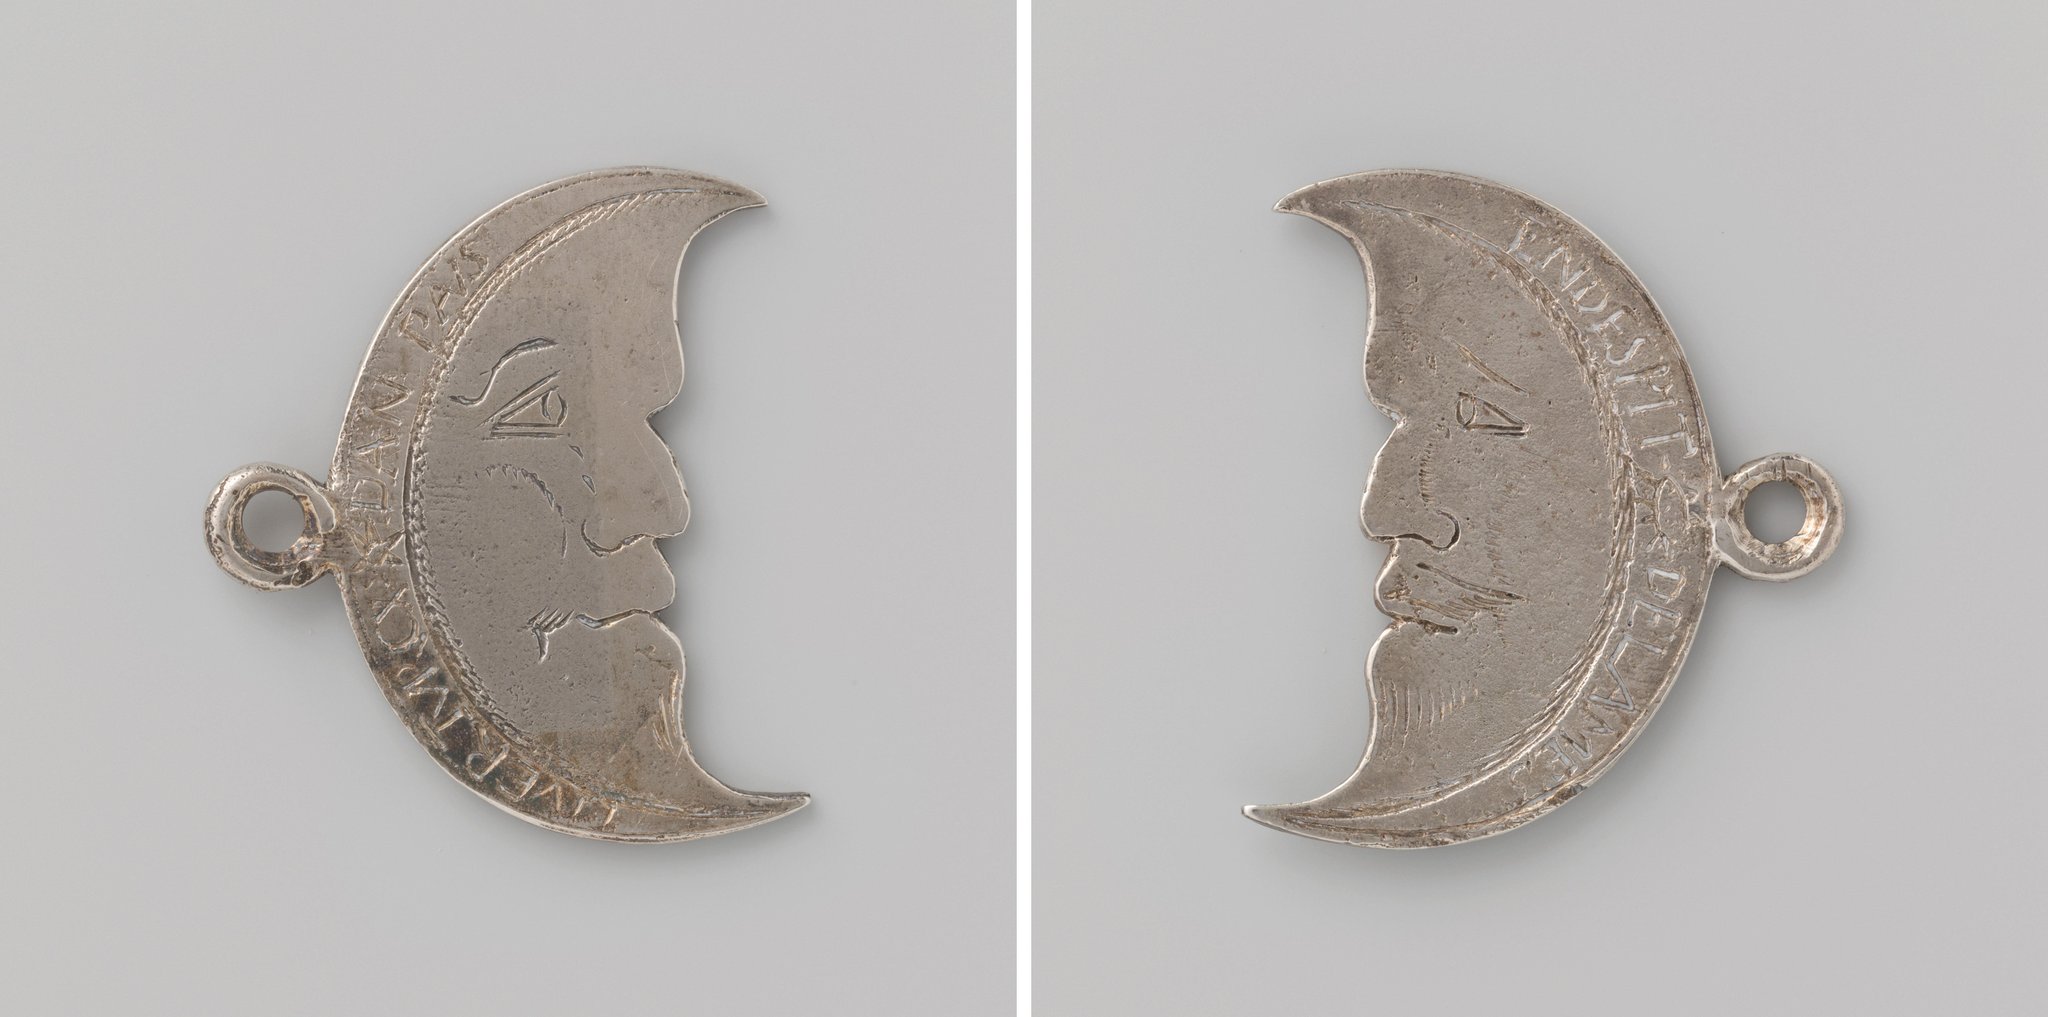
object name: beggar's medal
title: Halve maan door de 300 bootsgezellen van admiraal de Boisot gedragen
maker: Anonymous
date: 1574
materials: silver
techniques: engraving, striking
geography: netherlands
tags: brussels, leiden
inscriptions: circumscription: ‘ENDESPIT DELAMES’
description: When in 1566 several hundred Dutch noblemen petitioned the Spanish authorities for greater tolerance in matters of religion, they were ridiculed as 'gueux': beggars. In response, they took the French name 'gueux' (vulgarised to 'geuzen') as a symbol of honour and wore a beggar's badge on their clothes. These were tokens that town authorities gave to beggars to show that they were legally allowed to beg. The crescent shape of the medals and the text around the edge 'Better Turkish than Papish' had several connotations. Turks had a reputation for cruelty; but they were also known for their tolerance to other religions. Moreover, the Islamic Turkish Empire was at war with Catholic Spain. Apart from badges, the Geuzen also carried small wooden begging bowls and flasks, reminiscent of the pilgrims who lived by begging.